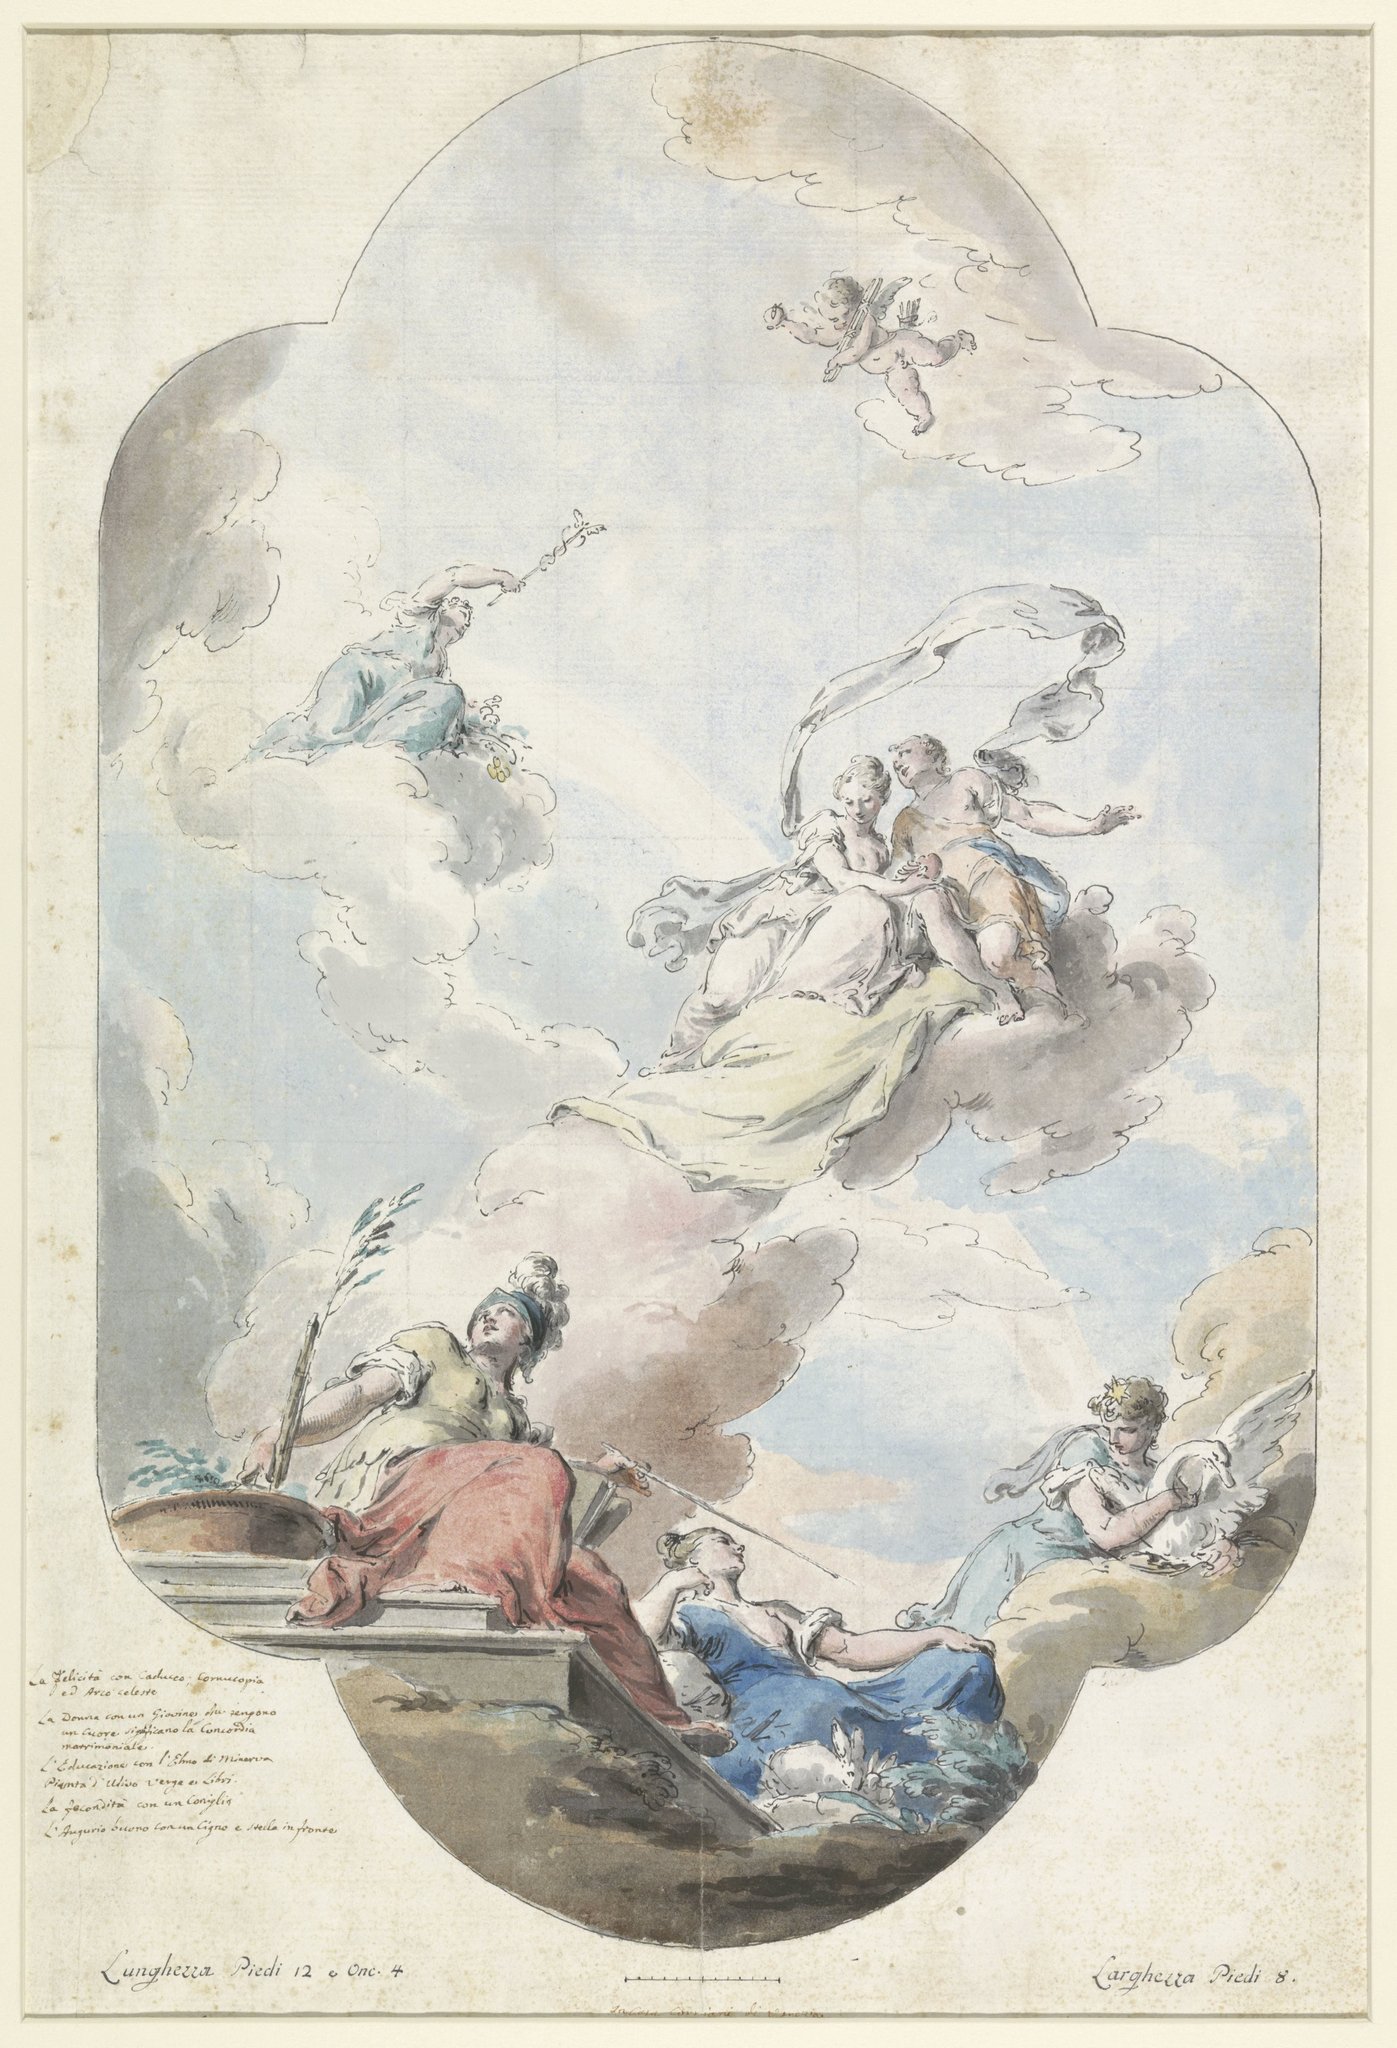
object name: watercolor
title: Design for a Ceiling Painting with a Nuptial Allegory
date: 1750-1775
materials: chalk, paper, watercolor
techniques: brush, pen, drawing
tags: minerva as patroness, symbolic representations, allegories and emblems ~ education; 'ammaestramento', dottrina', 'educatione', 'istitutione' (ripa), happiness, felicity, 'benevolenza et unione matrimoniale', 'concordia maritale' (ripa), fruitfulness, productiveness, fertility, fecundity; 'fecondità' (ripa), good omen; 'augurio buono' (ripa)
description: The now almost forgotten Novelli was once an important artist in Venice. He painted many decorations in the city’s palaces. As an art theorist, he propagated a style that wanted to abolish the old disegno (design or drawing) versus colore (colour) rivalry. The drawing’s inscriptions make it clear that the representation was designed for a marriage. Centrally depicted are a man and a woman together holding a heart.